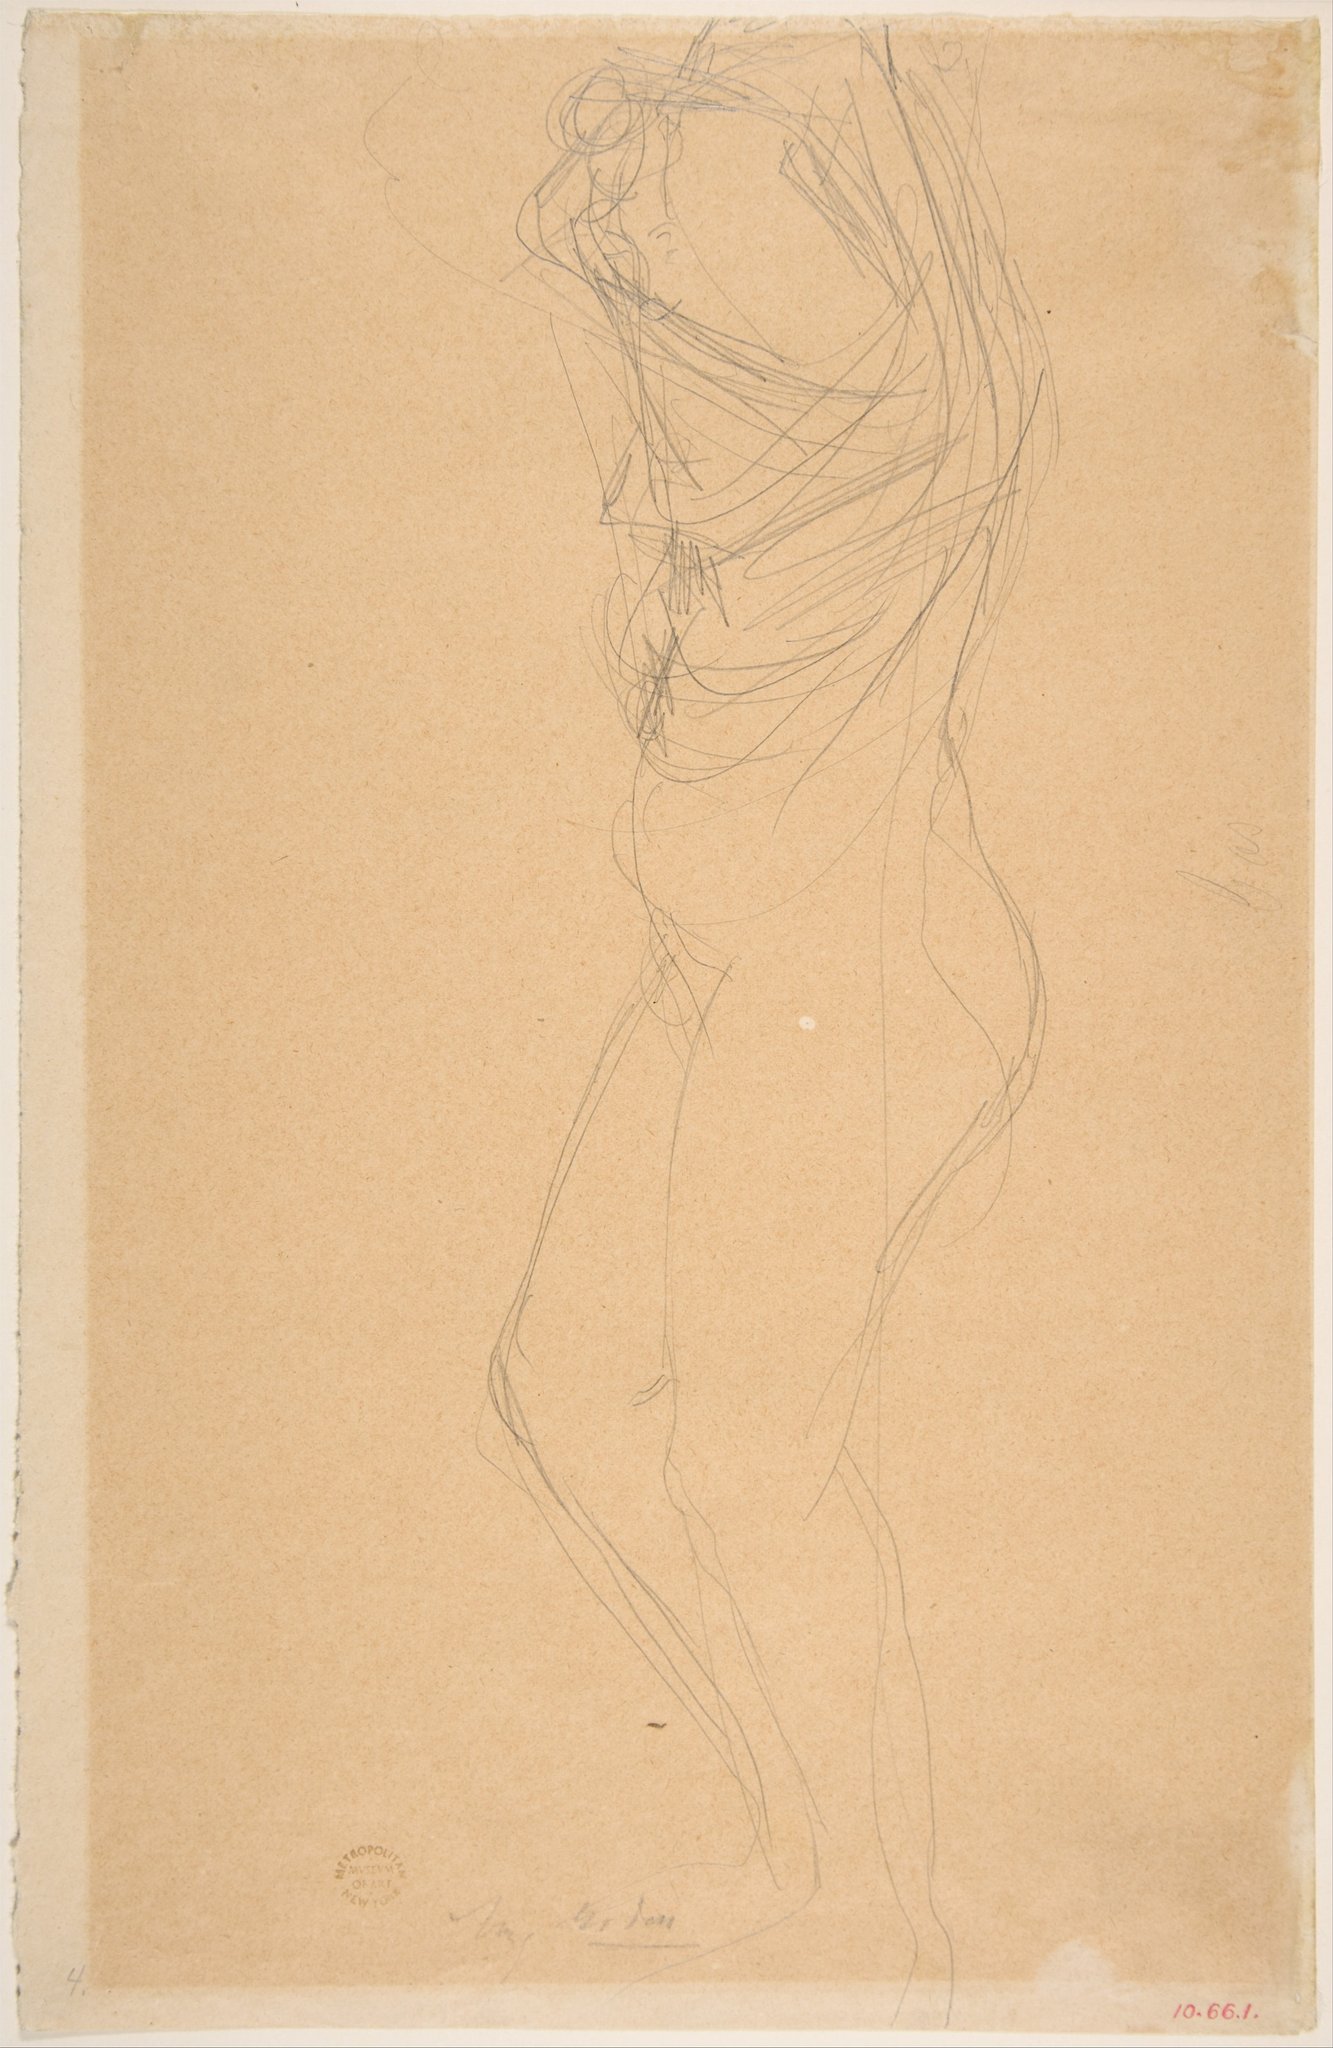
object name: drawing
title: Figure Disrobing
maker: auguste rodin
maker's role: artist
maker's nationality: french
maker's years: 1840-1917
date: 1900-1910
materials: graphite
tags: female nudes